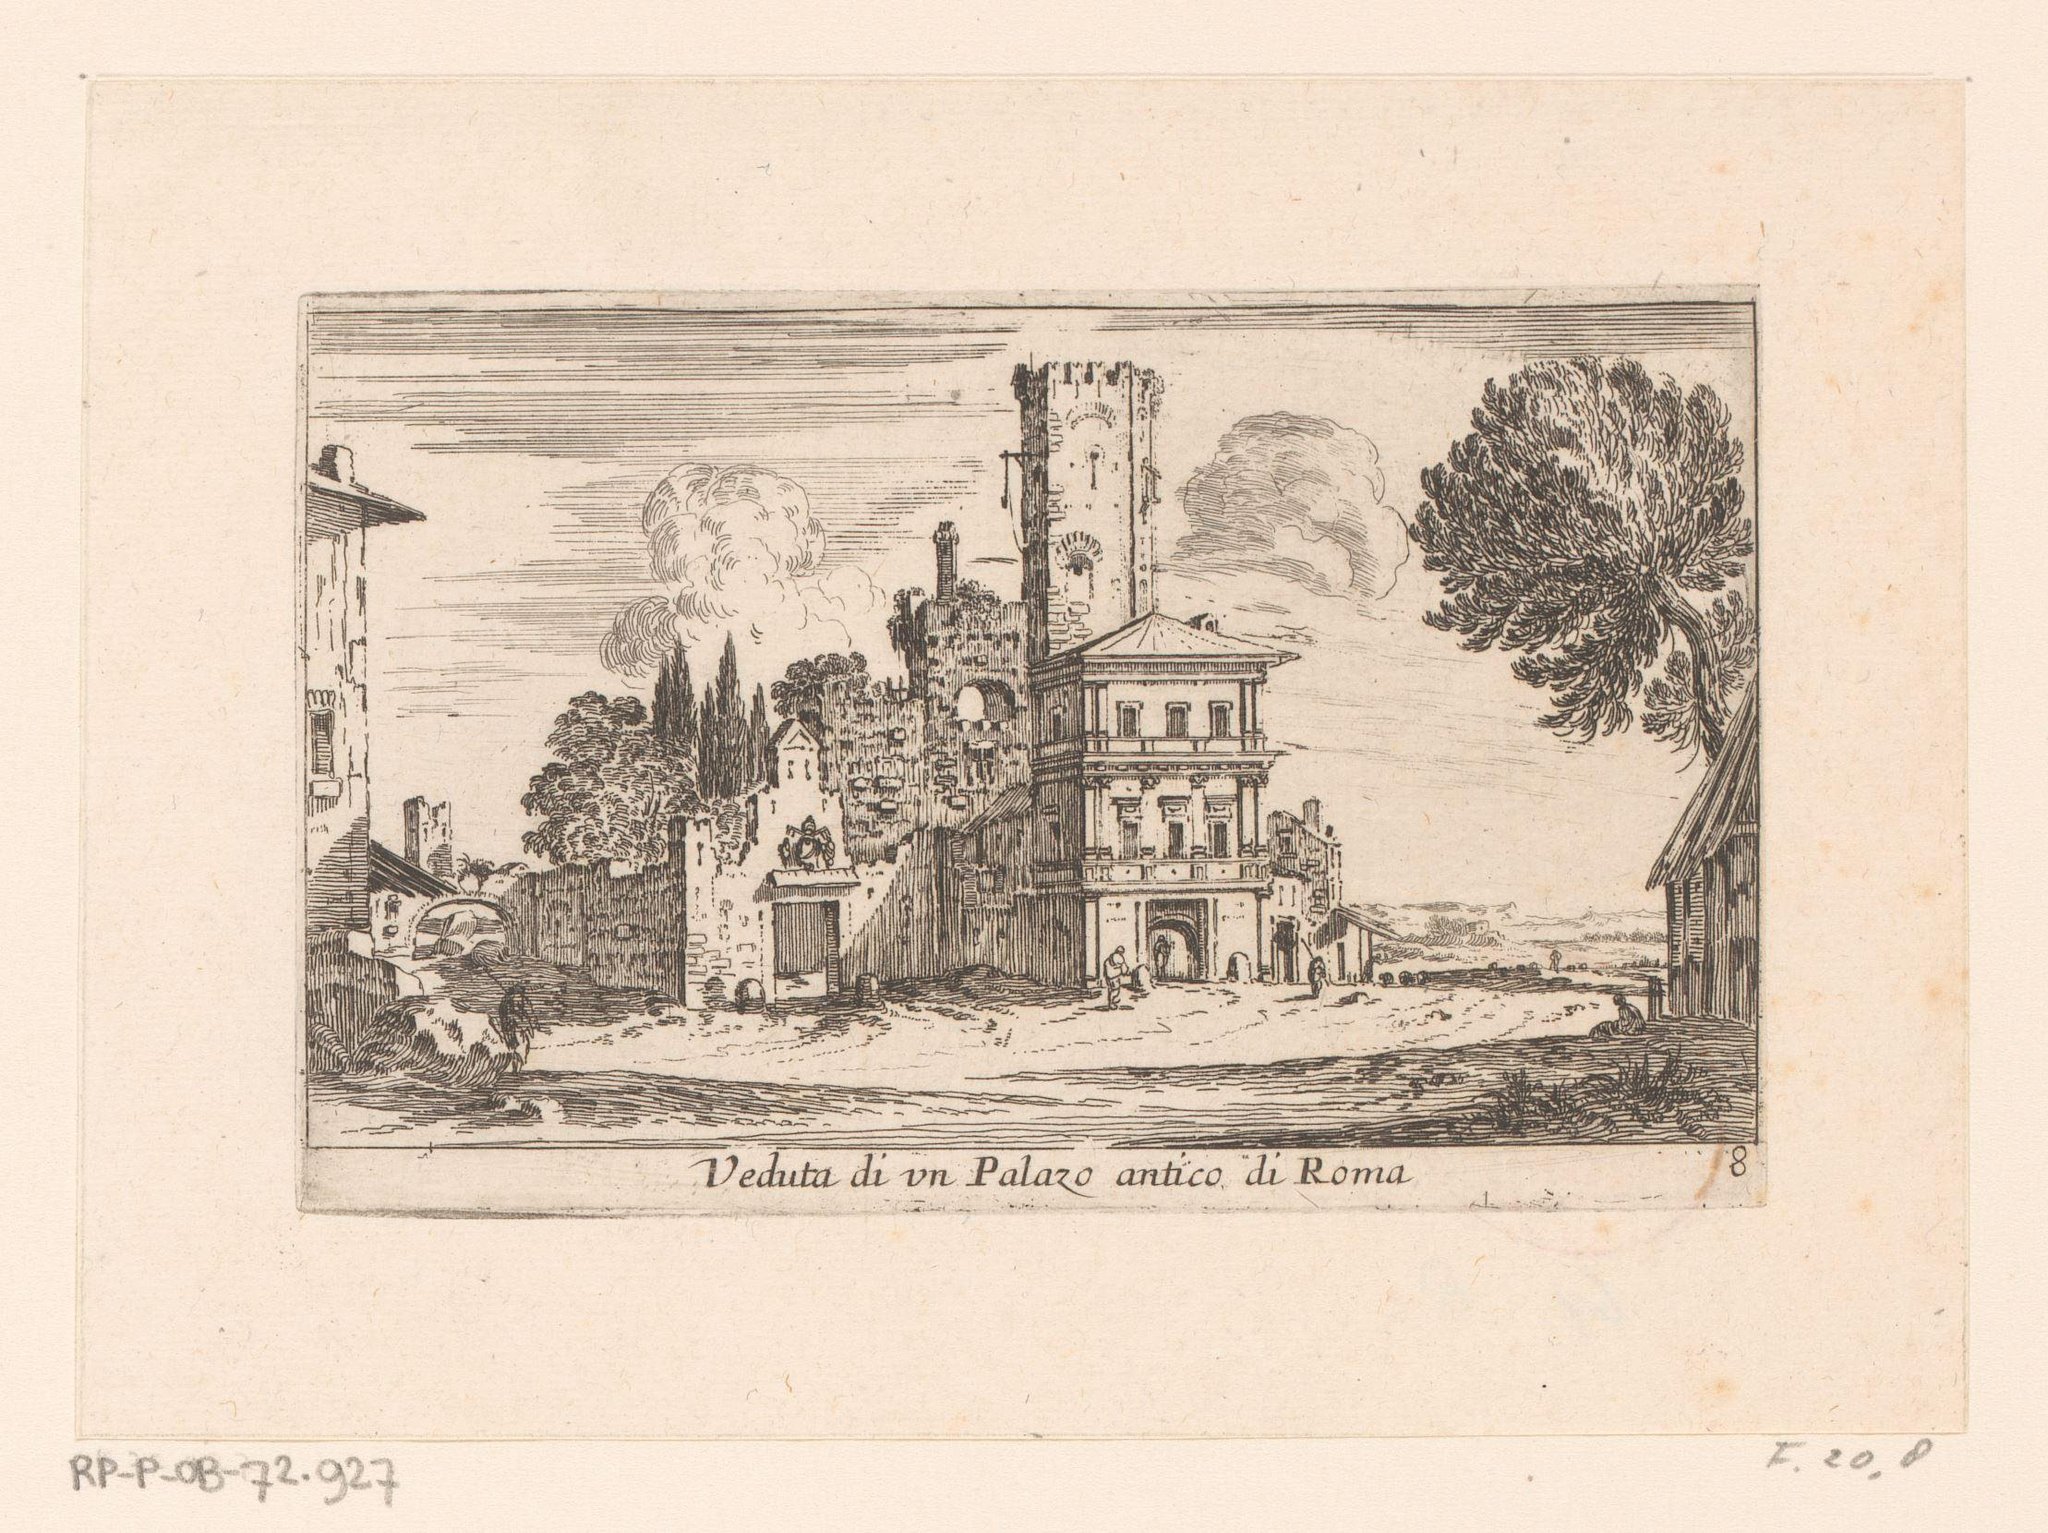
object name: print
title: Gezicht op een paleis in Rome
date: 1631-1657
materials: paper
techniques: etching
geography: france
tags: landscape with tower or castle, rome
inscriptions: collector's mark: Lugt 240